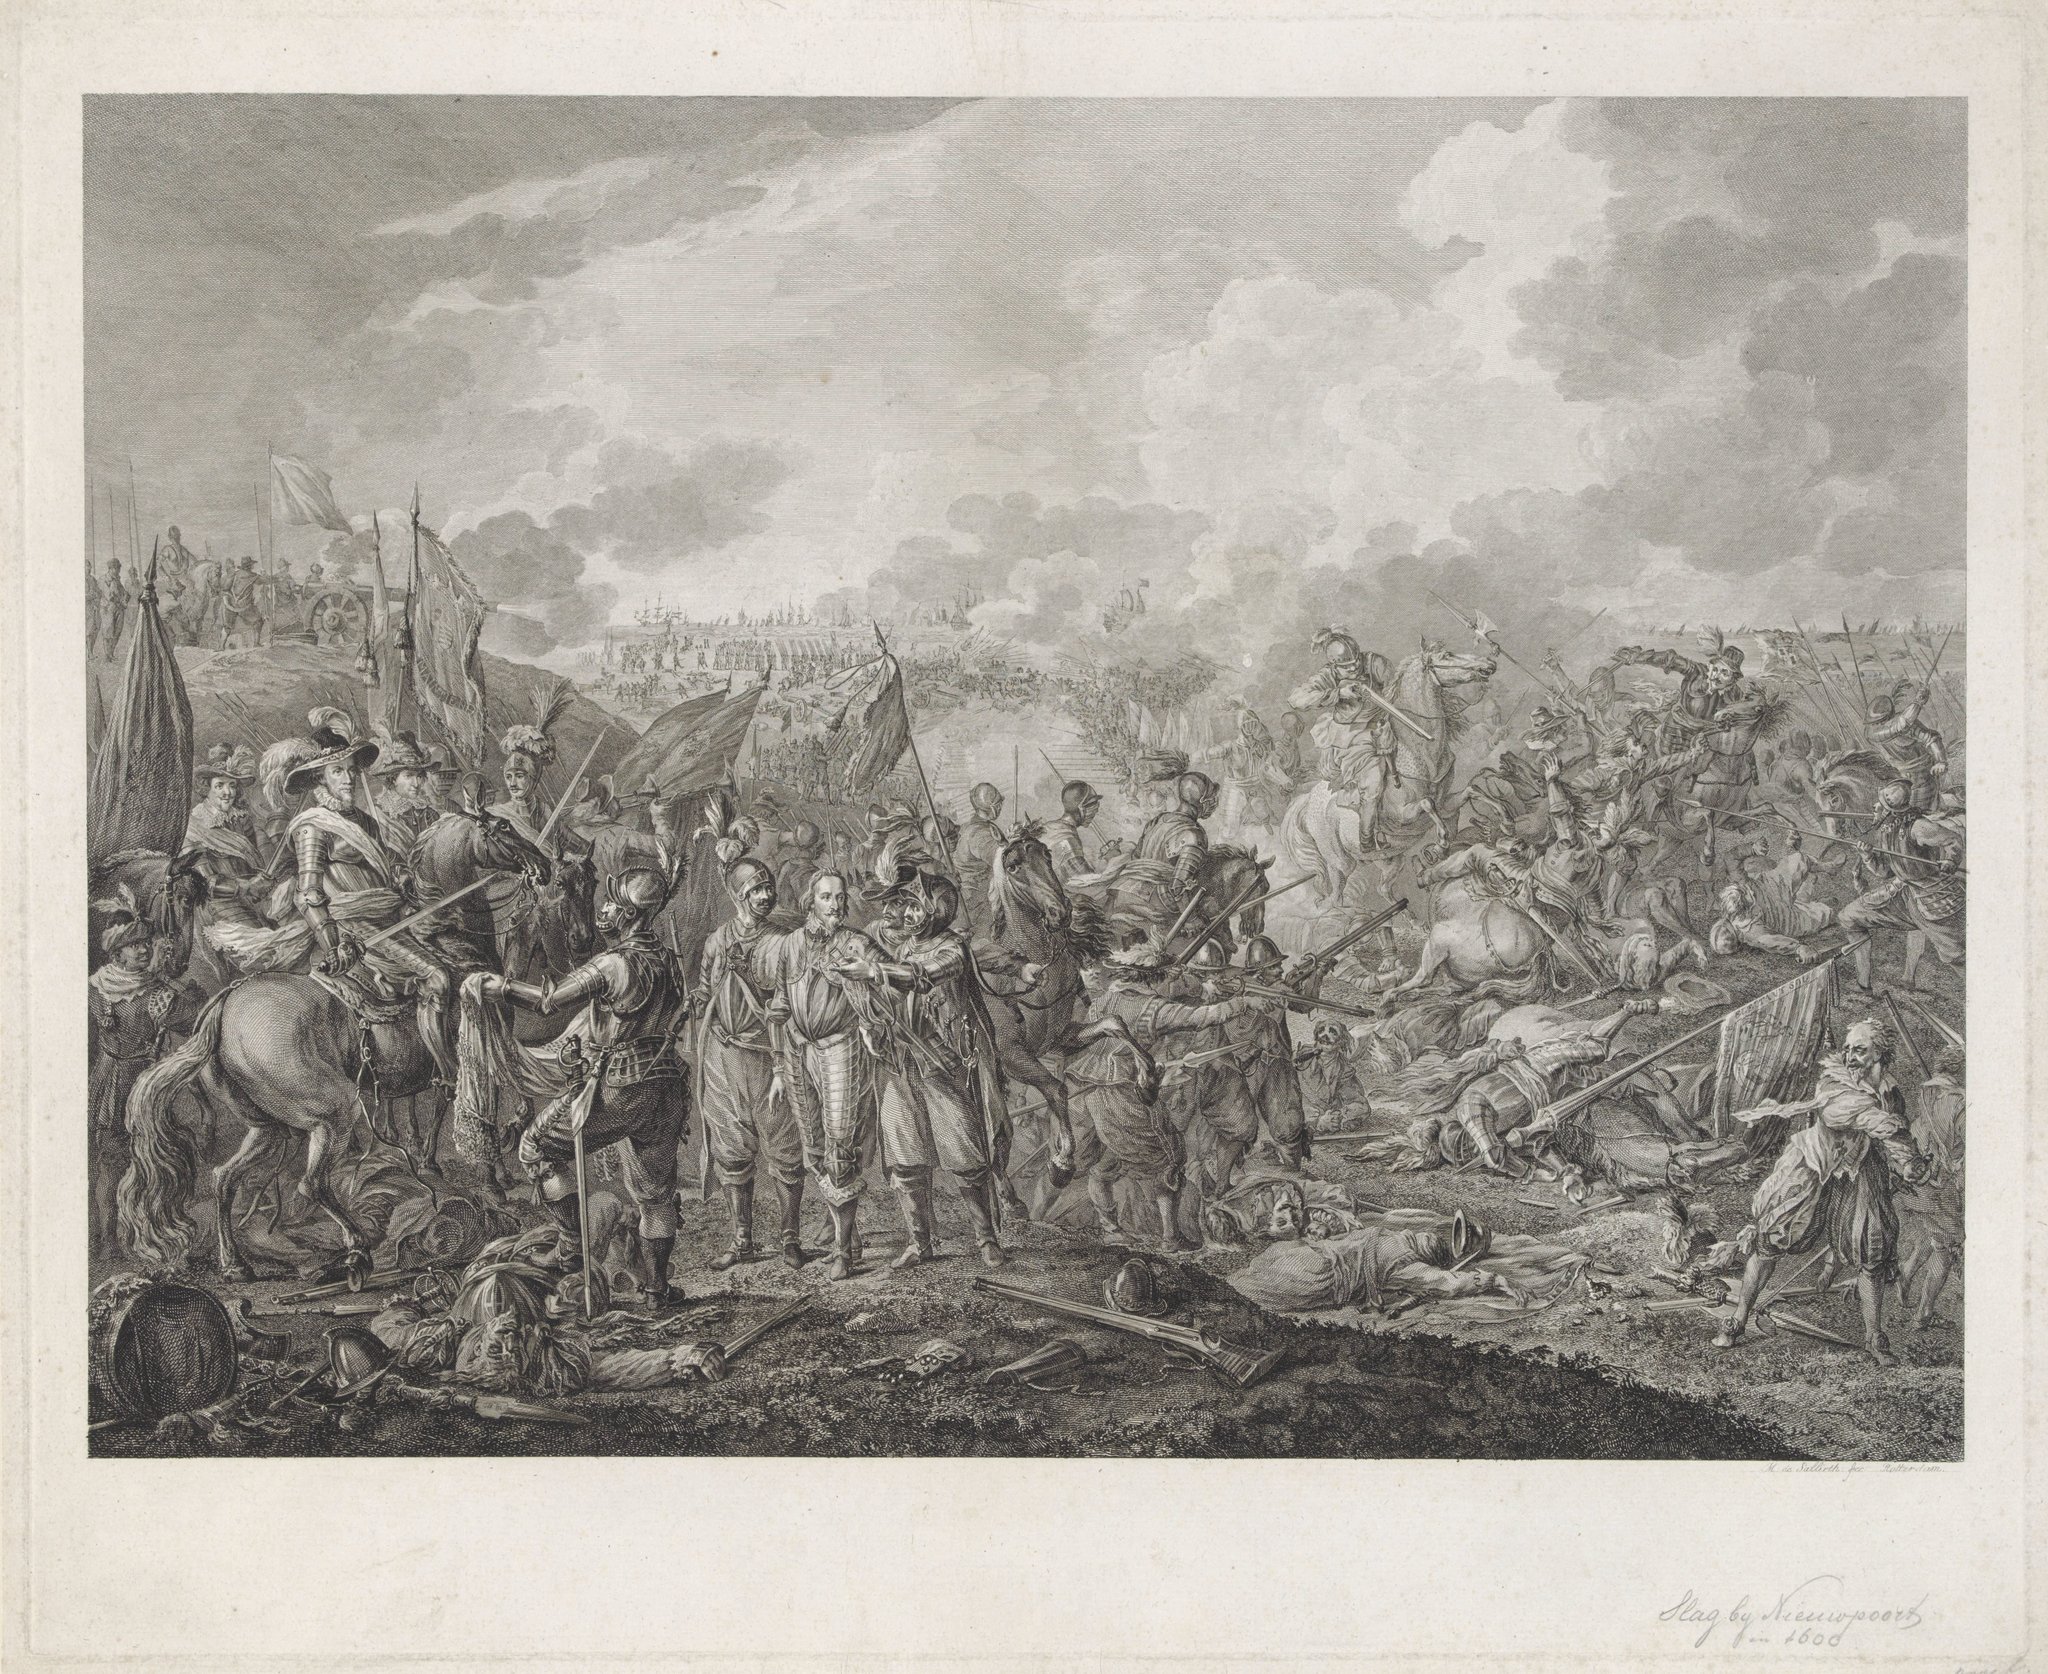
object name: print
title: Maurits behaalt de overwinning bij de slag bij Nieuwpoort, 1600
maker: mathias de sallieth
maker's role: print maker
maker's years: 1749-1791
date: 1775-1791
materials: paper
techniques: engraving, etching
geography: rotterdam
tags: the hague, maurice (prince of orange), battle (+ land forces), battle of nieuwpoort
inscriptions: collector's mark: Lugt 2228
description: De slag bij Nieuwpoort, 2 juli 1600. Op de voorgrond links prins Maurits te paard, omgeven door soldaten en officieren, de gevangen genomen Franciscus van Mendoza wordt naar de prins geleid. Op de achtergrond woedt de veldslag.